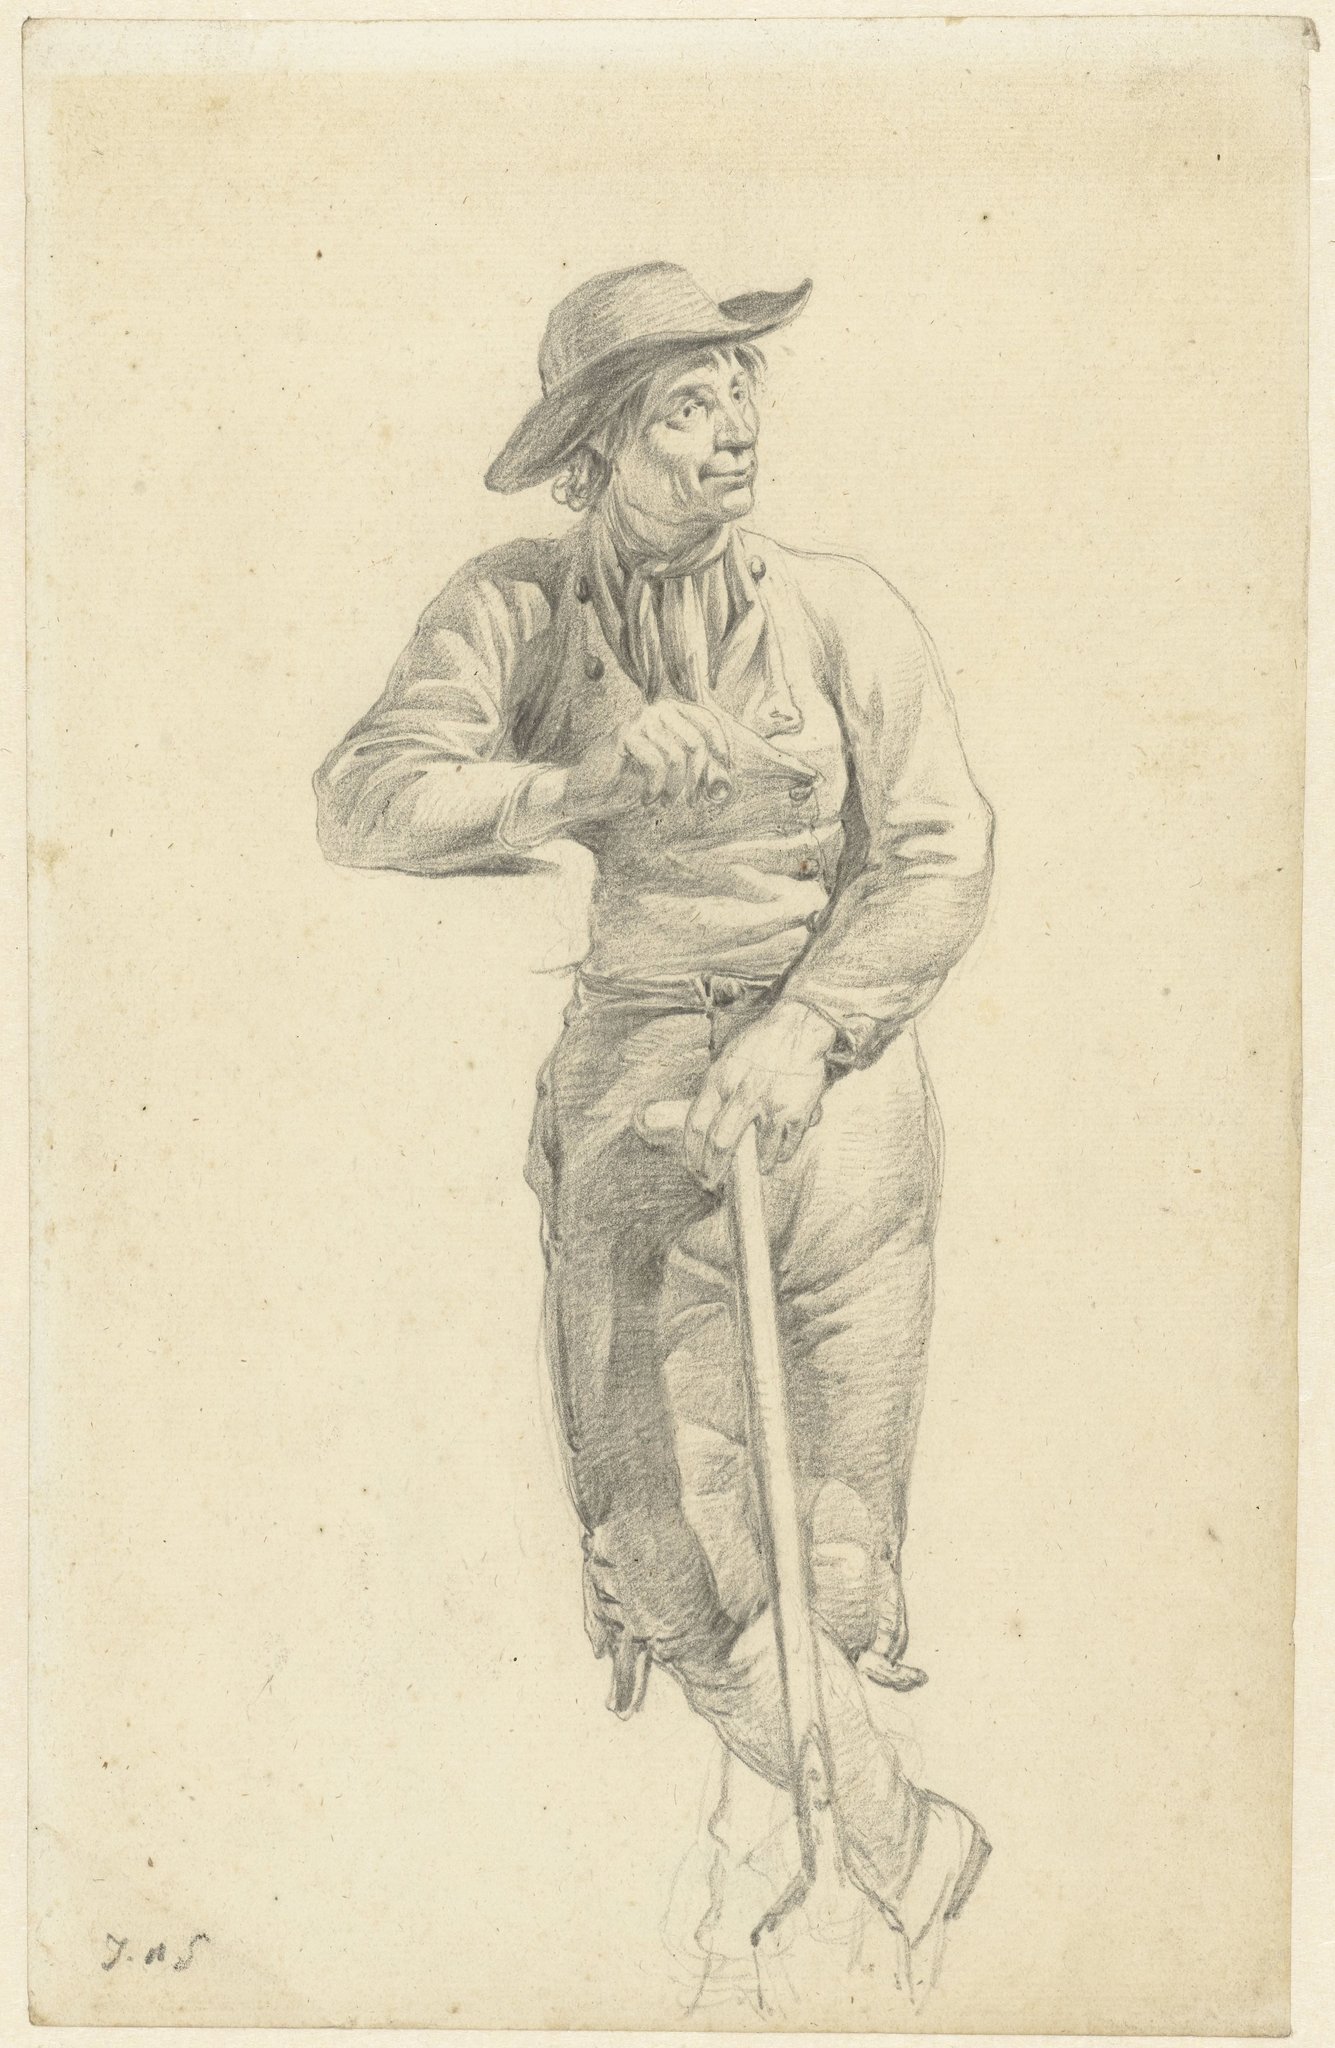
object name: drawing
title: Staande boer met pijp en spade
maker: jacob van strij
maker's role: draughtsman, painter, print maker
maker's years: 1756-1815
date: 1766-1815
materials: chalk, paper, pencil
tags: agricultural implements: spade, postures of the human figure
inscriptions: signature: ‘J. v S’